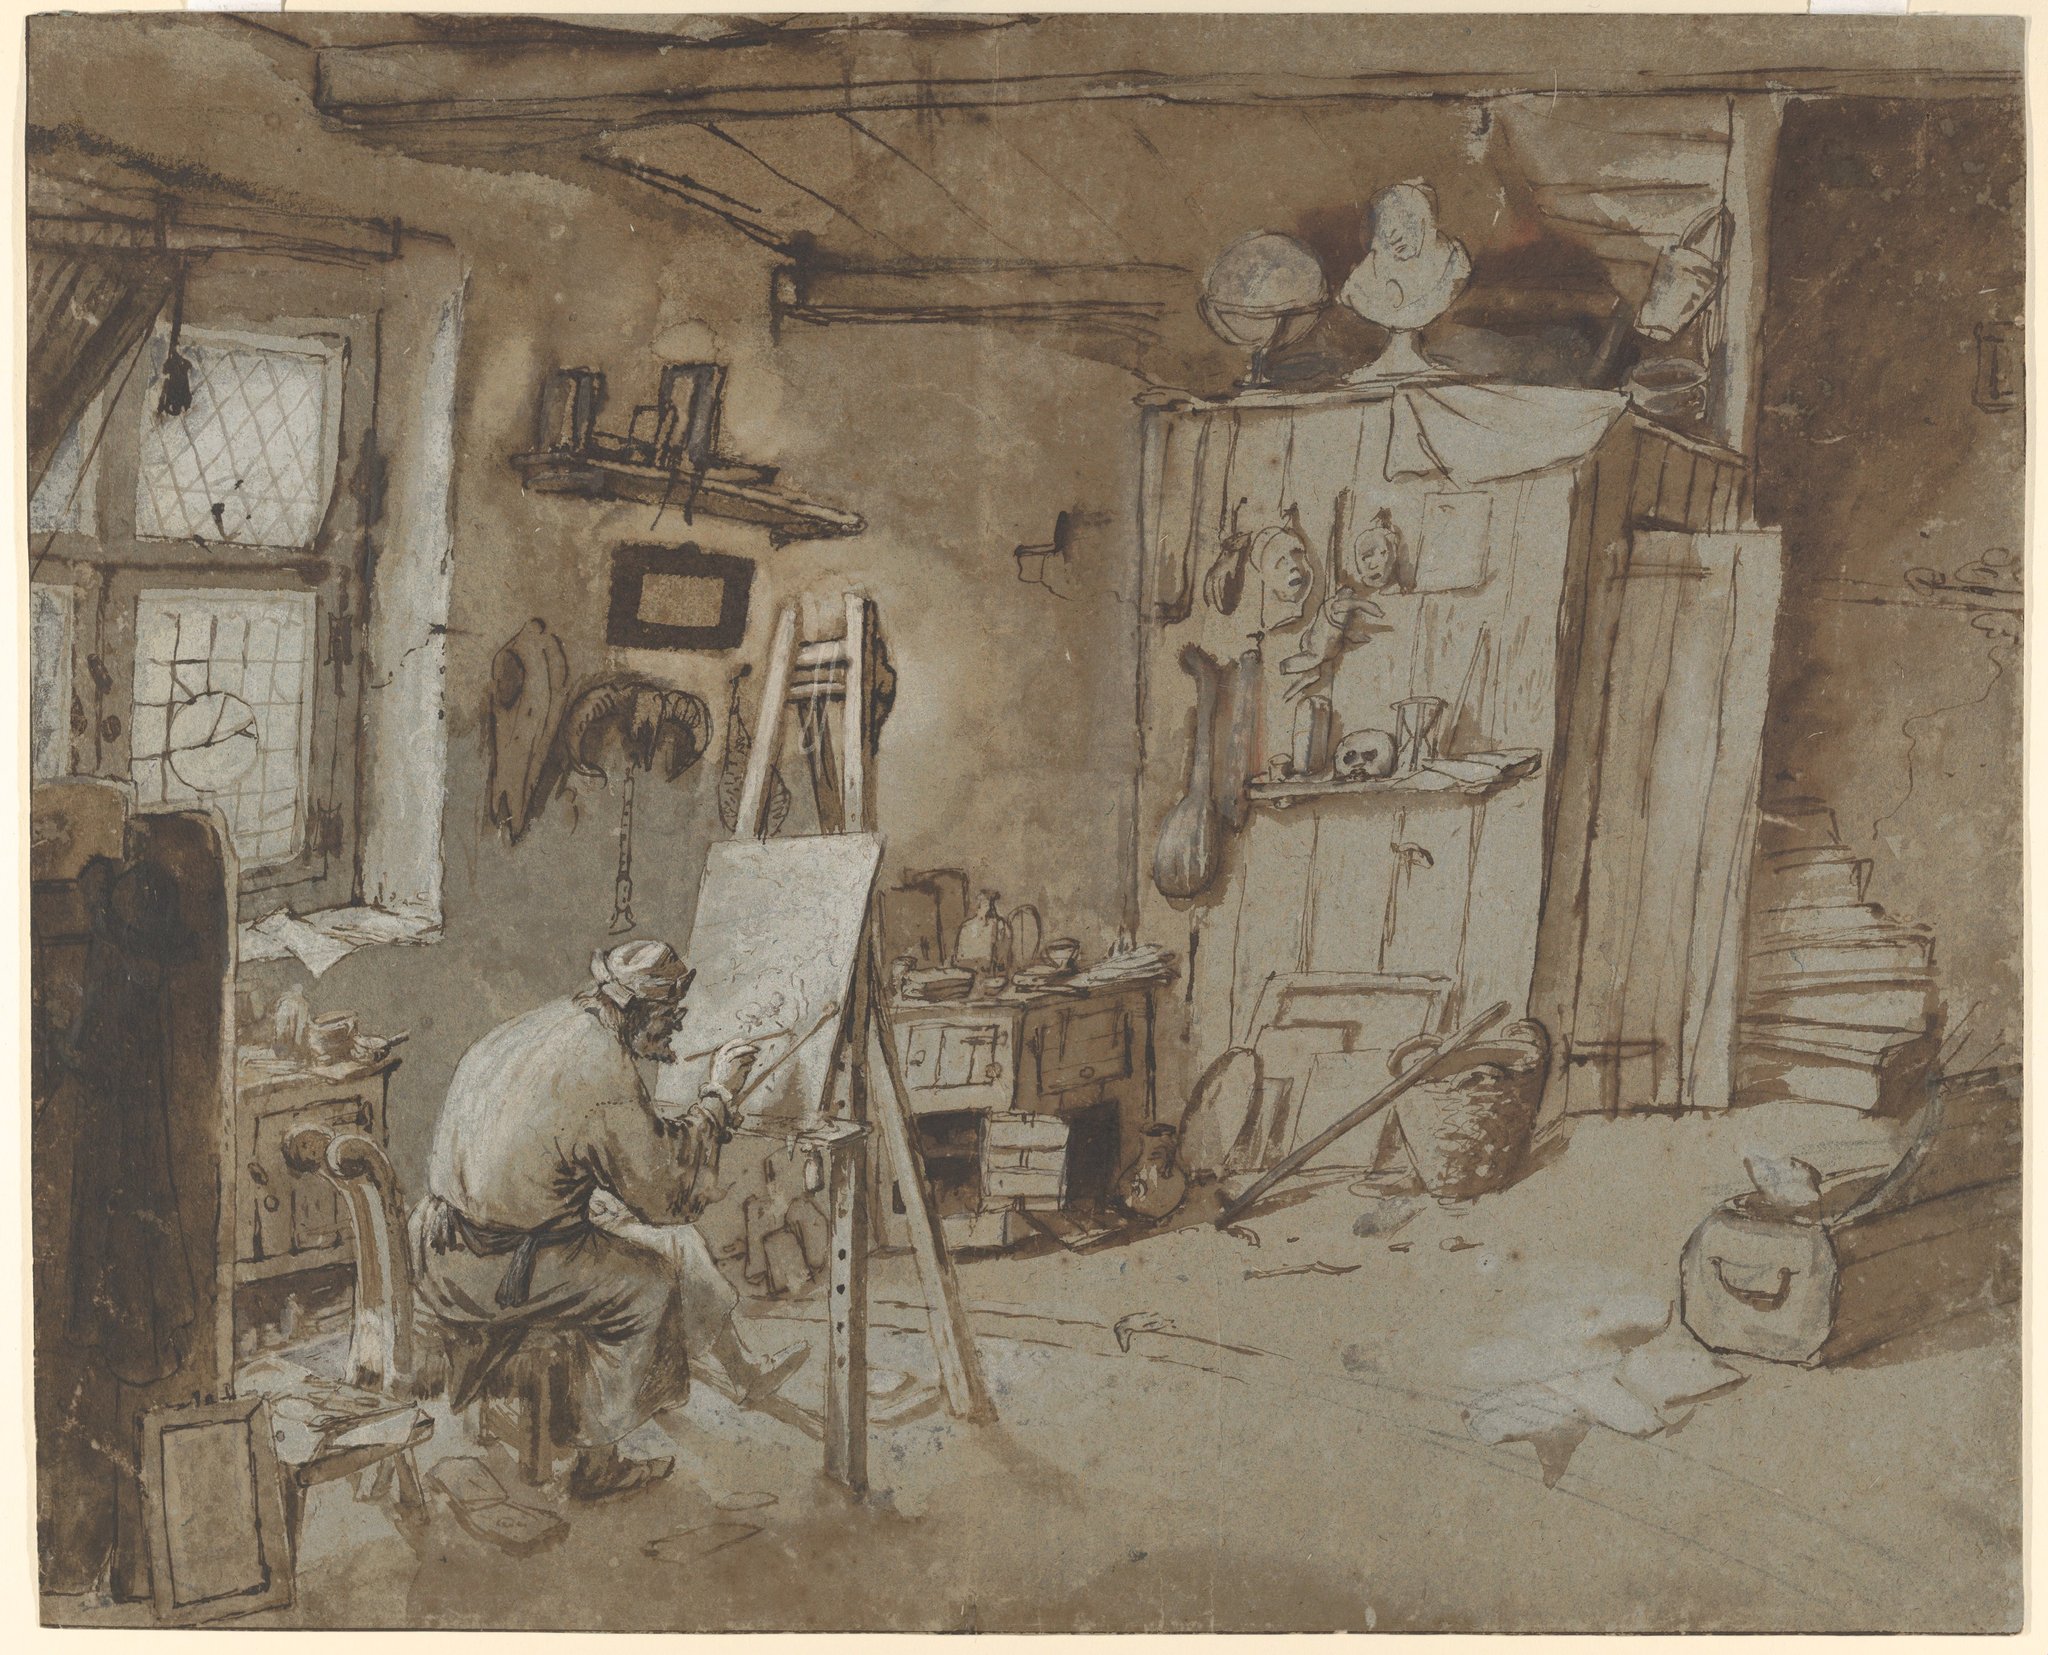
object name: drawing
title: A Painter at Work in his Studio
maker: thomas wijck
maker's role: artist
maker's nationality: dutch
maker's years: 1616-1677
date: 1663-1677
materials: chalk, gouache, ink, paper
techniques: brush, heightening, pen, wash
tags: painting,interiors,men